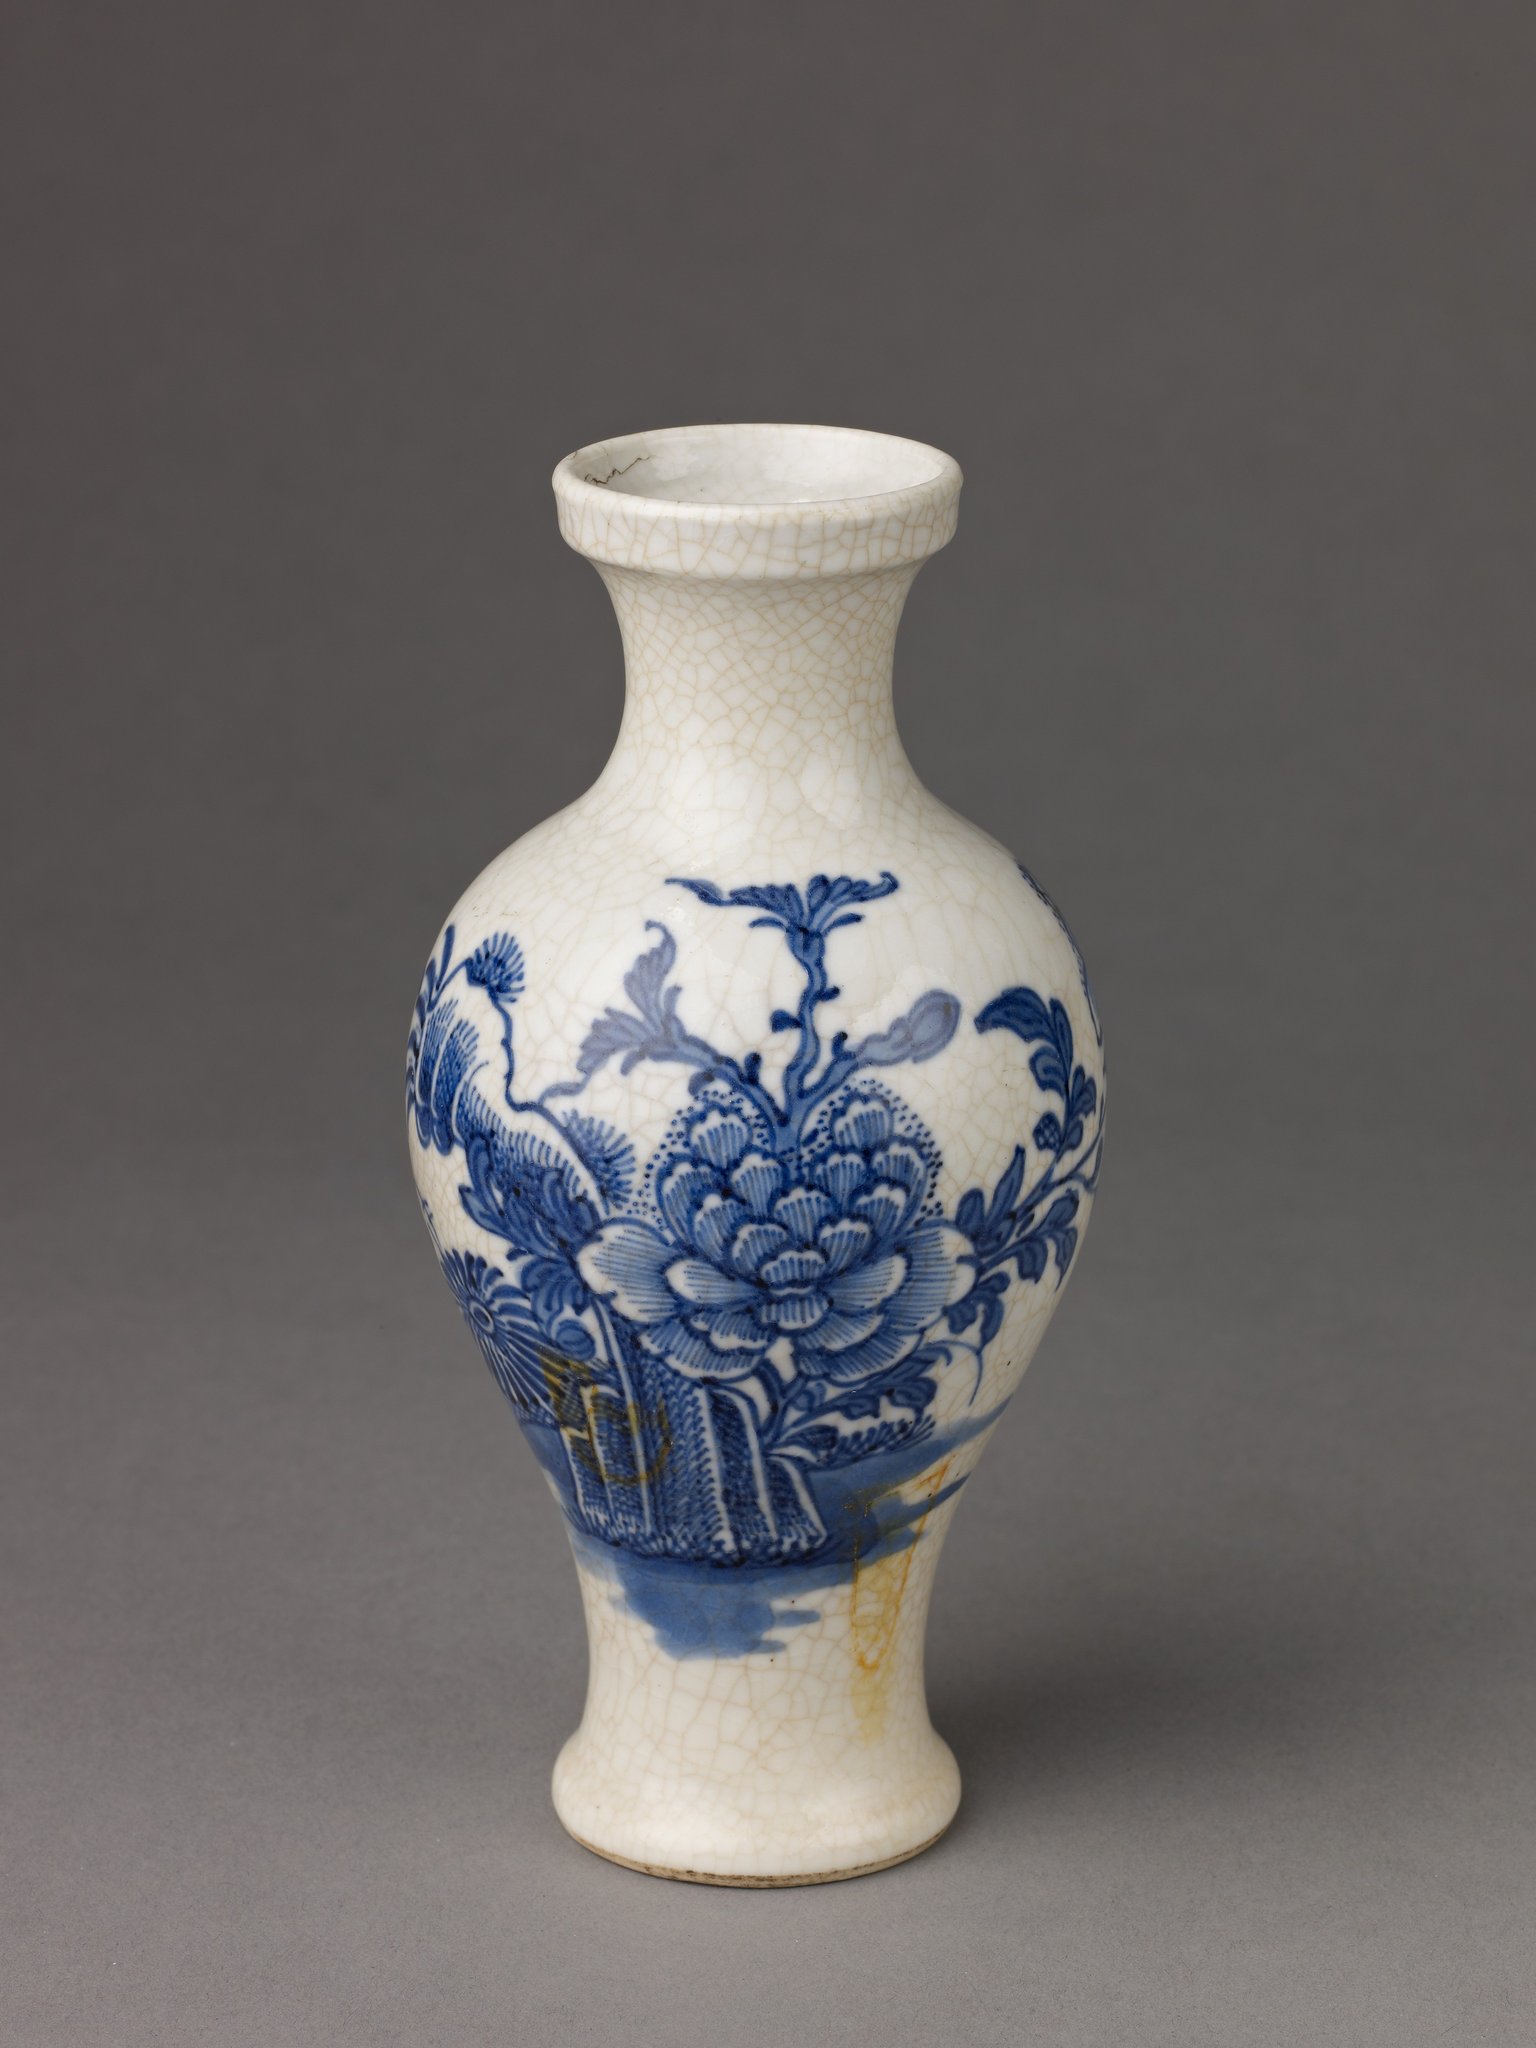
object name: vase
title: Small vase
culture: chinese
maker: chinese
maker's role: artist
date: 1801-1900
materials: paste, porcelain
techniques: painting, underglaze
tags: flowers